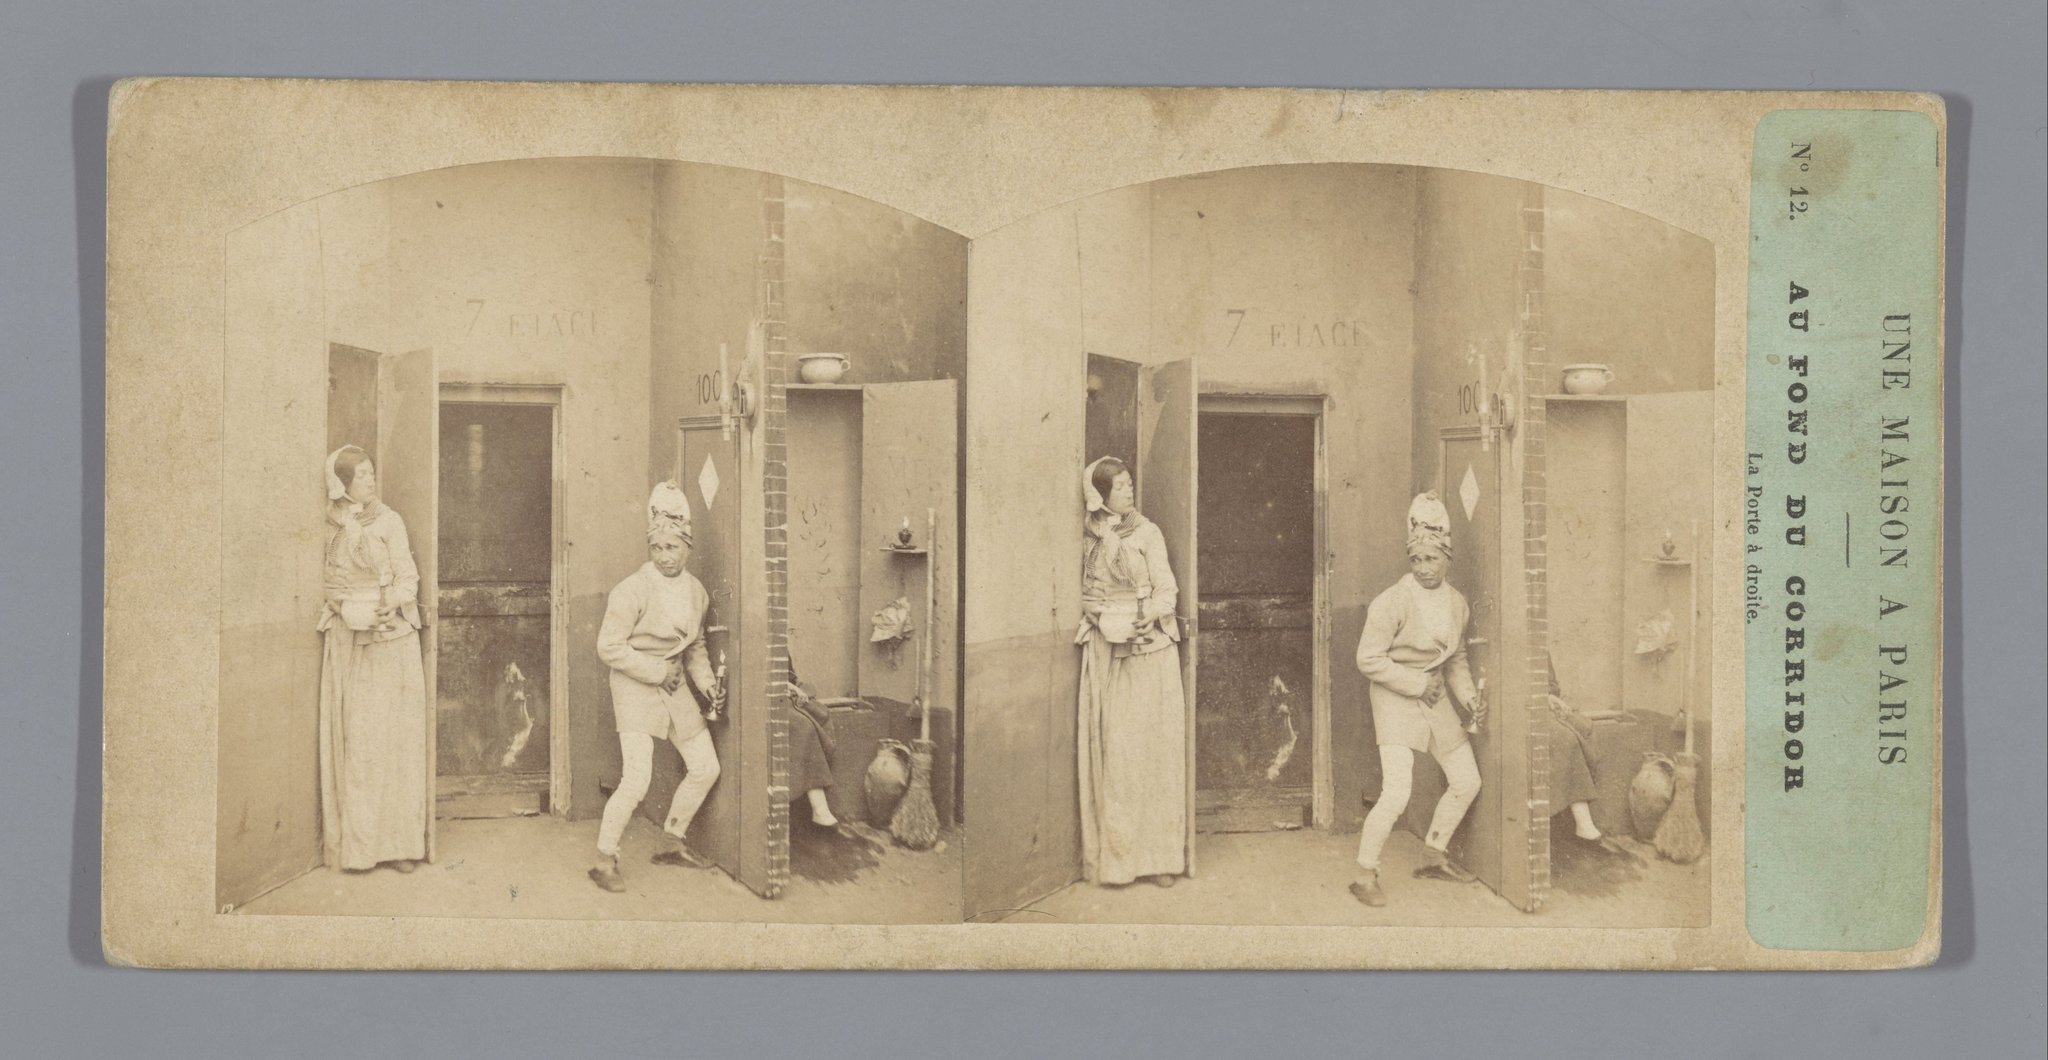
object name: stereograph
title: Theatrale voorstelling van een man wachtend op de gang voor de deur van een bezet toilet en een vrouw in een deuropening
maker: Anonymous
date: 1850-1880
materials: cardboard, photographic support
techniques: albumen print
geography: france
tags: set, scenery ~ stage, gallery (spacious corridor), paris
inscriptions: number: ‘No 12.’